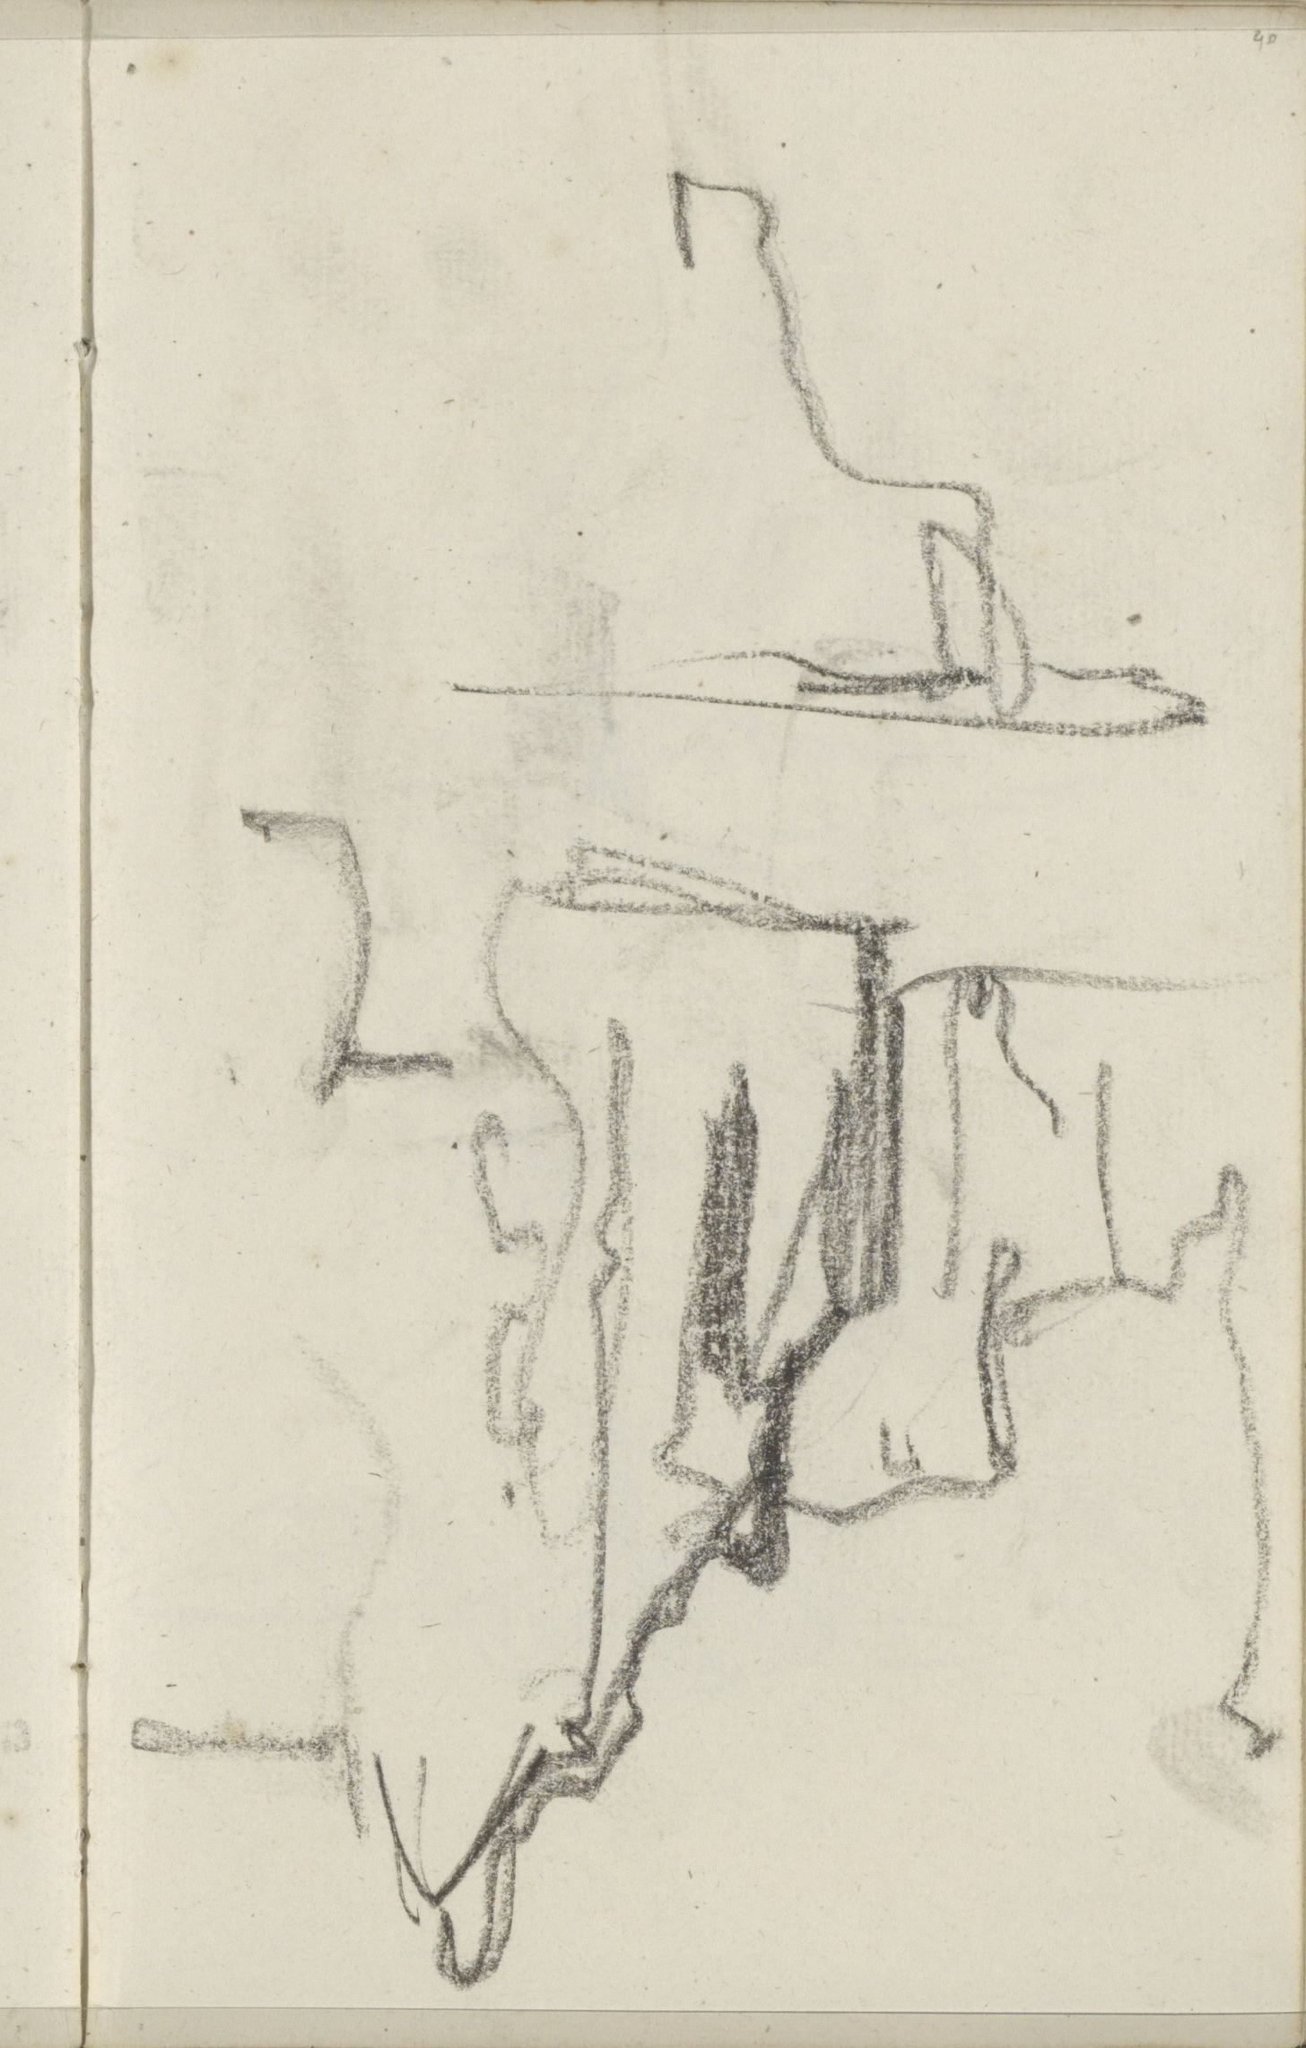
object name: sketchbook leaf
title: Gebouwen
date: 1880-1882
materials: chalk, paper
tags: architecture, civic architecture; edifices; dwellings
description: Pagina 40 uit een schetsboek met 31 bladen.